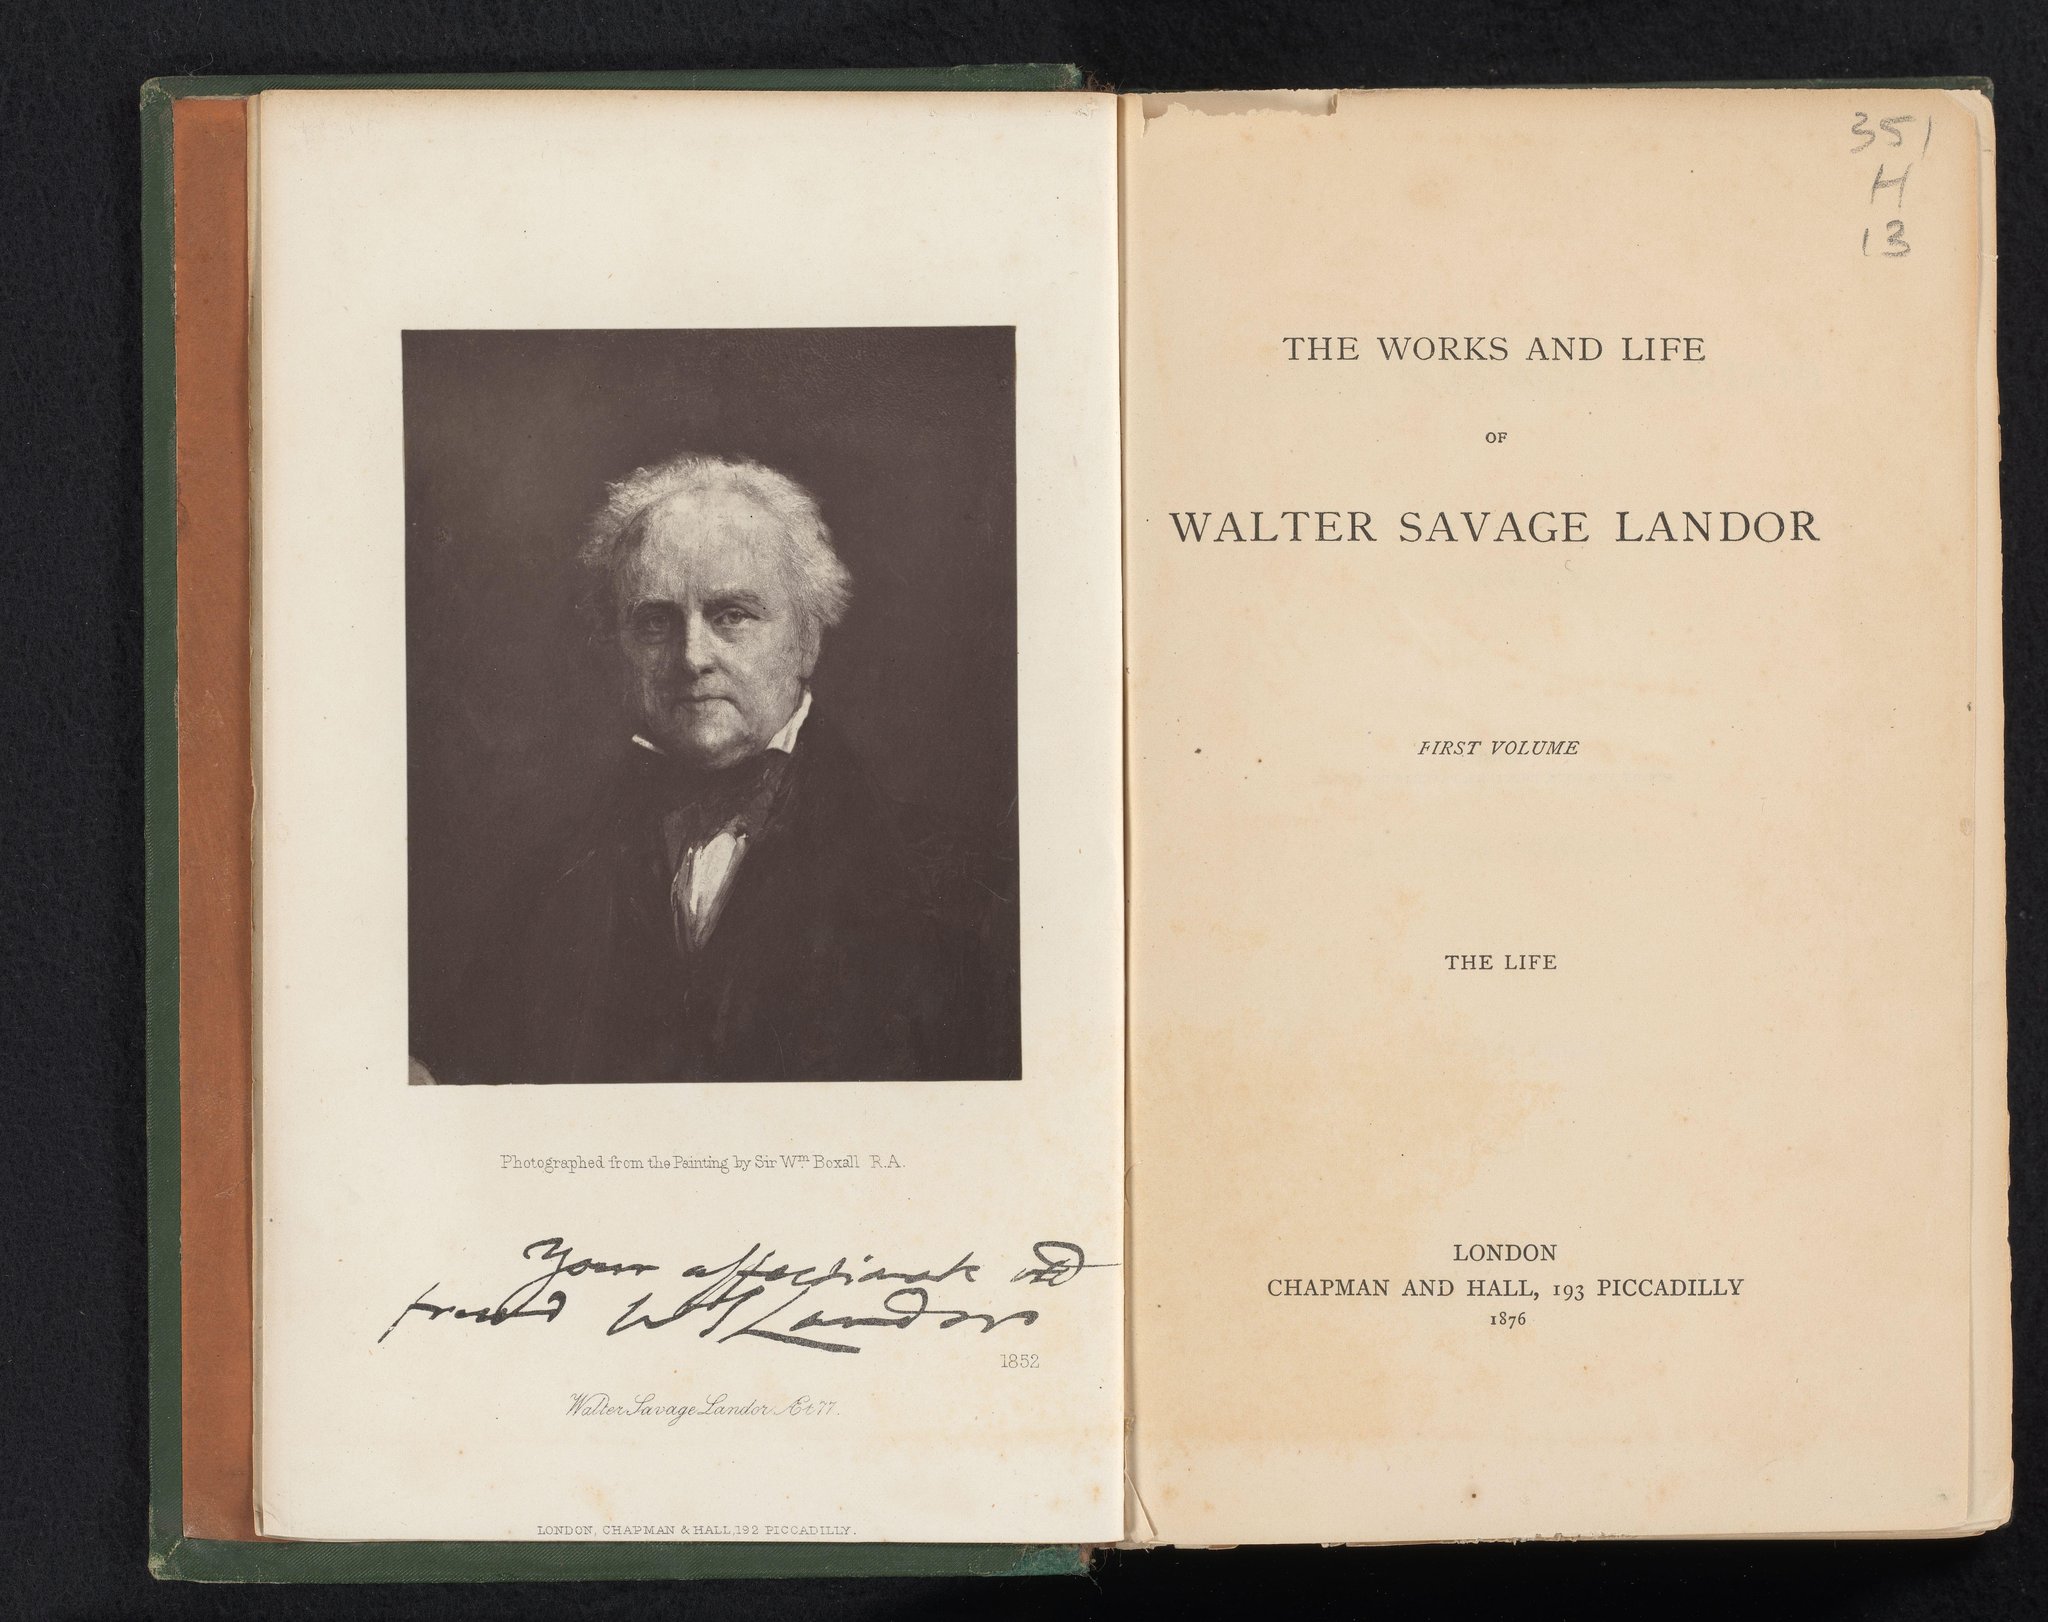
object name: book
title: The works and life of Walter Savage Landor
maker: john forster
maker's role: biograaf, schrijver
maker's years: 1812-1876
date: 1876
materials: cardboard, paper, textile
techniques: printing, woodburytype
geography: london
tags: walter savage landor